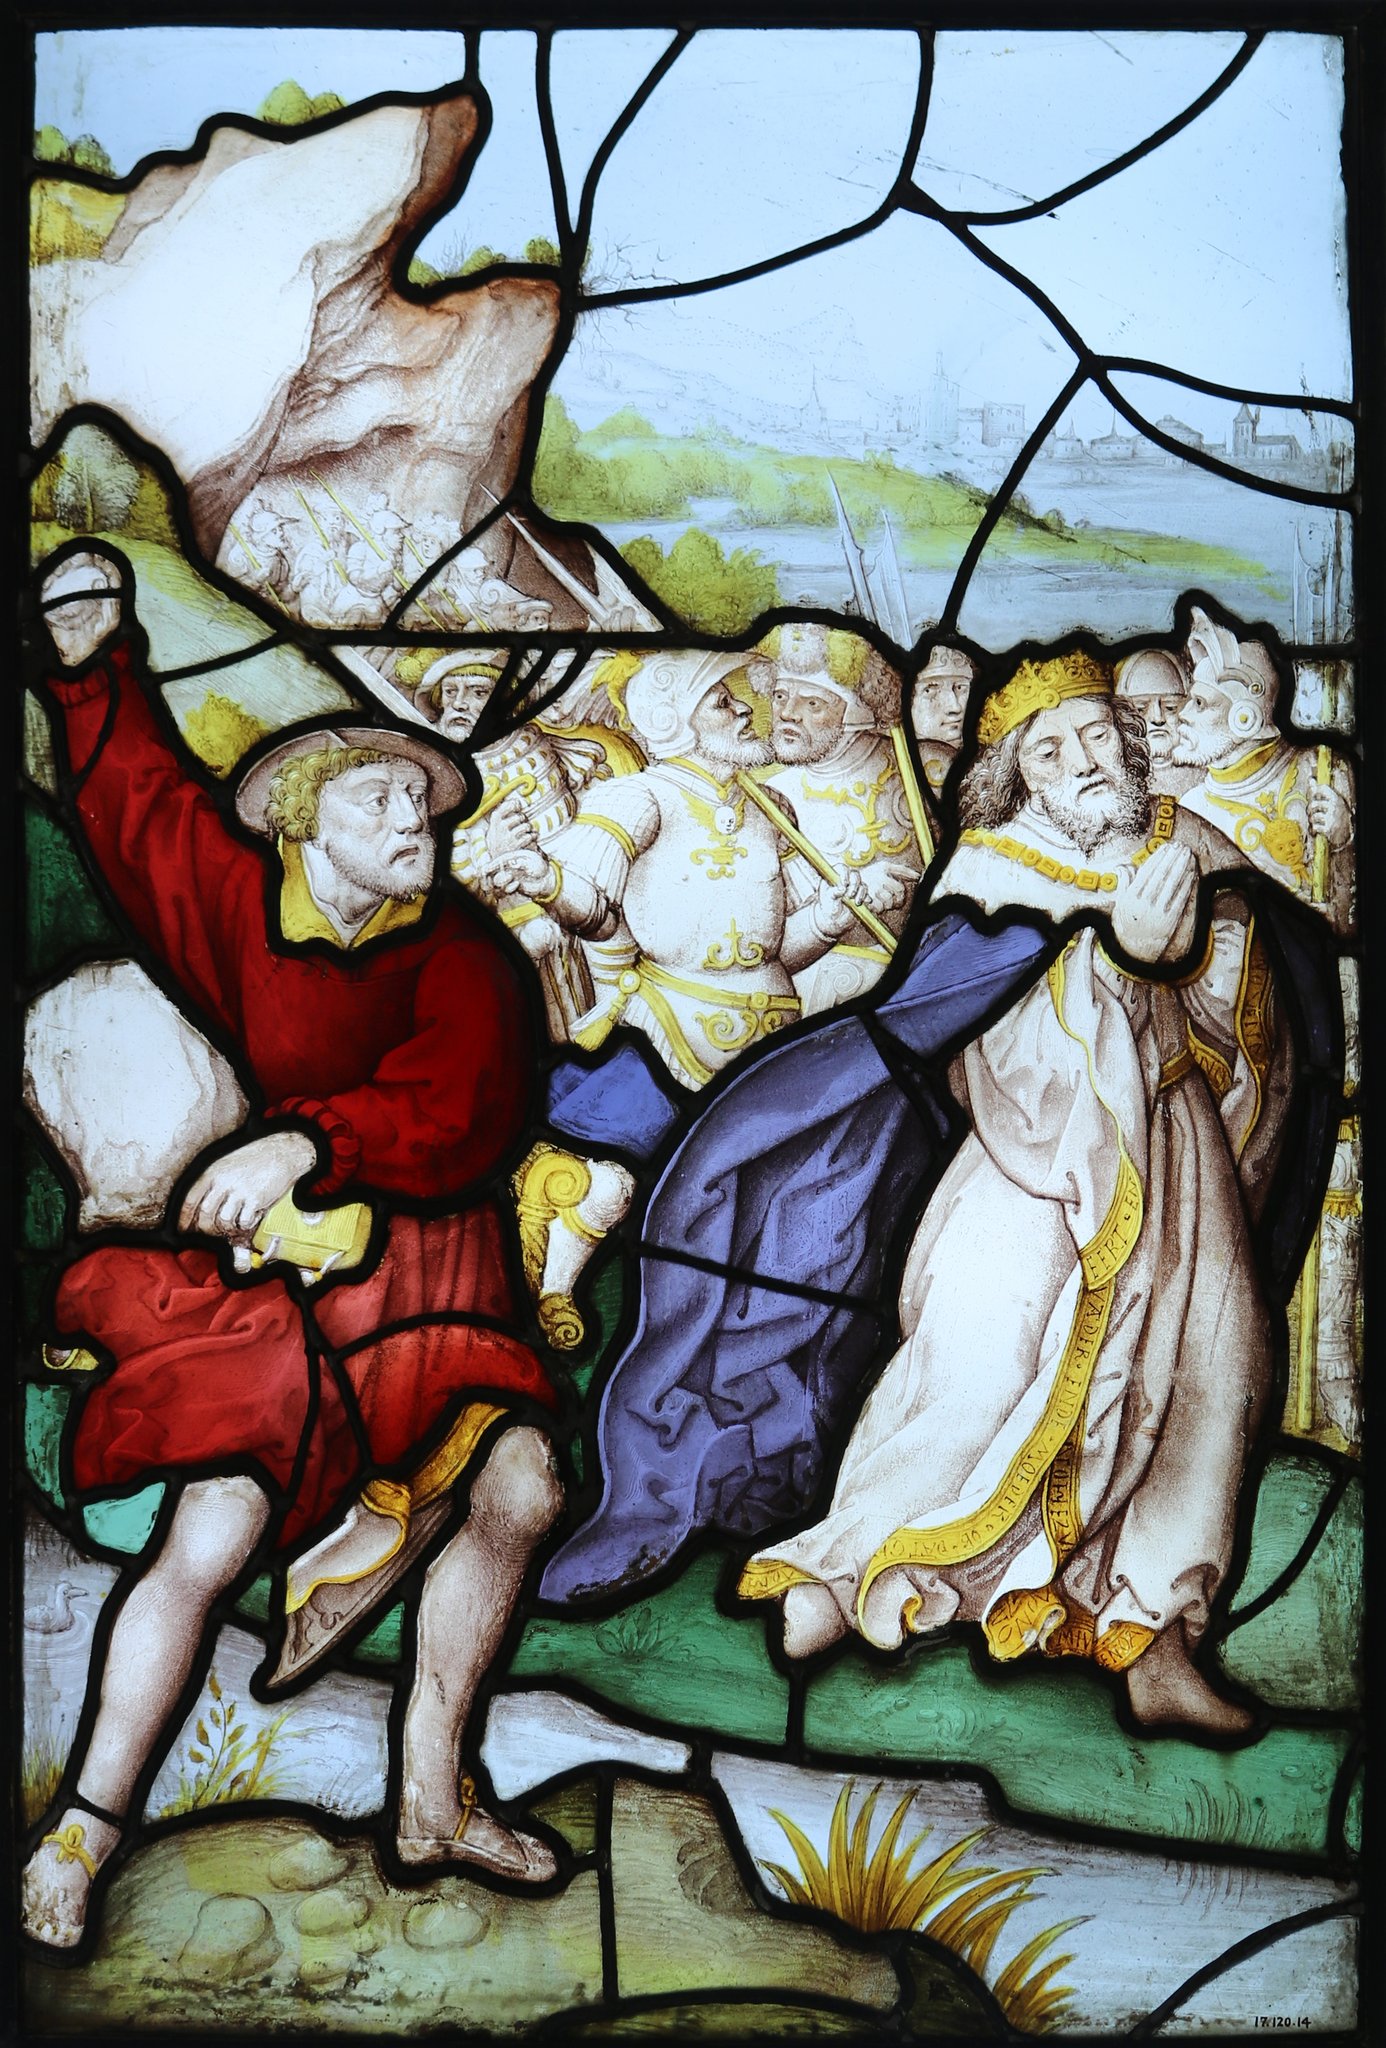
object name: panel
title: King David driven from Jerusalem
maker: jan rombouts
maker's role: maker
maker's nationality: south netherlandish (duchy of brabant)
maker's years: 1475-1535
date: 1501-1550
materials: glass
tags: men,david